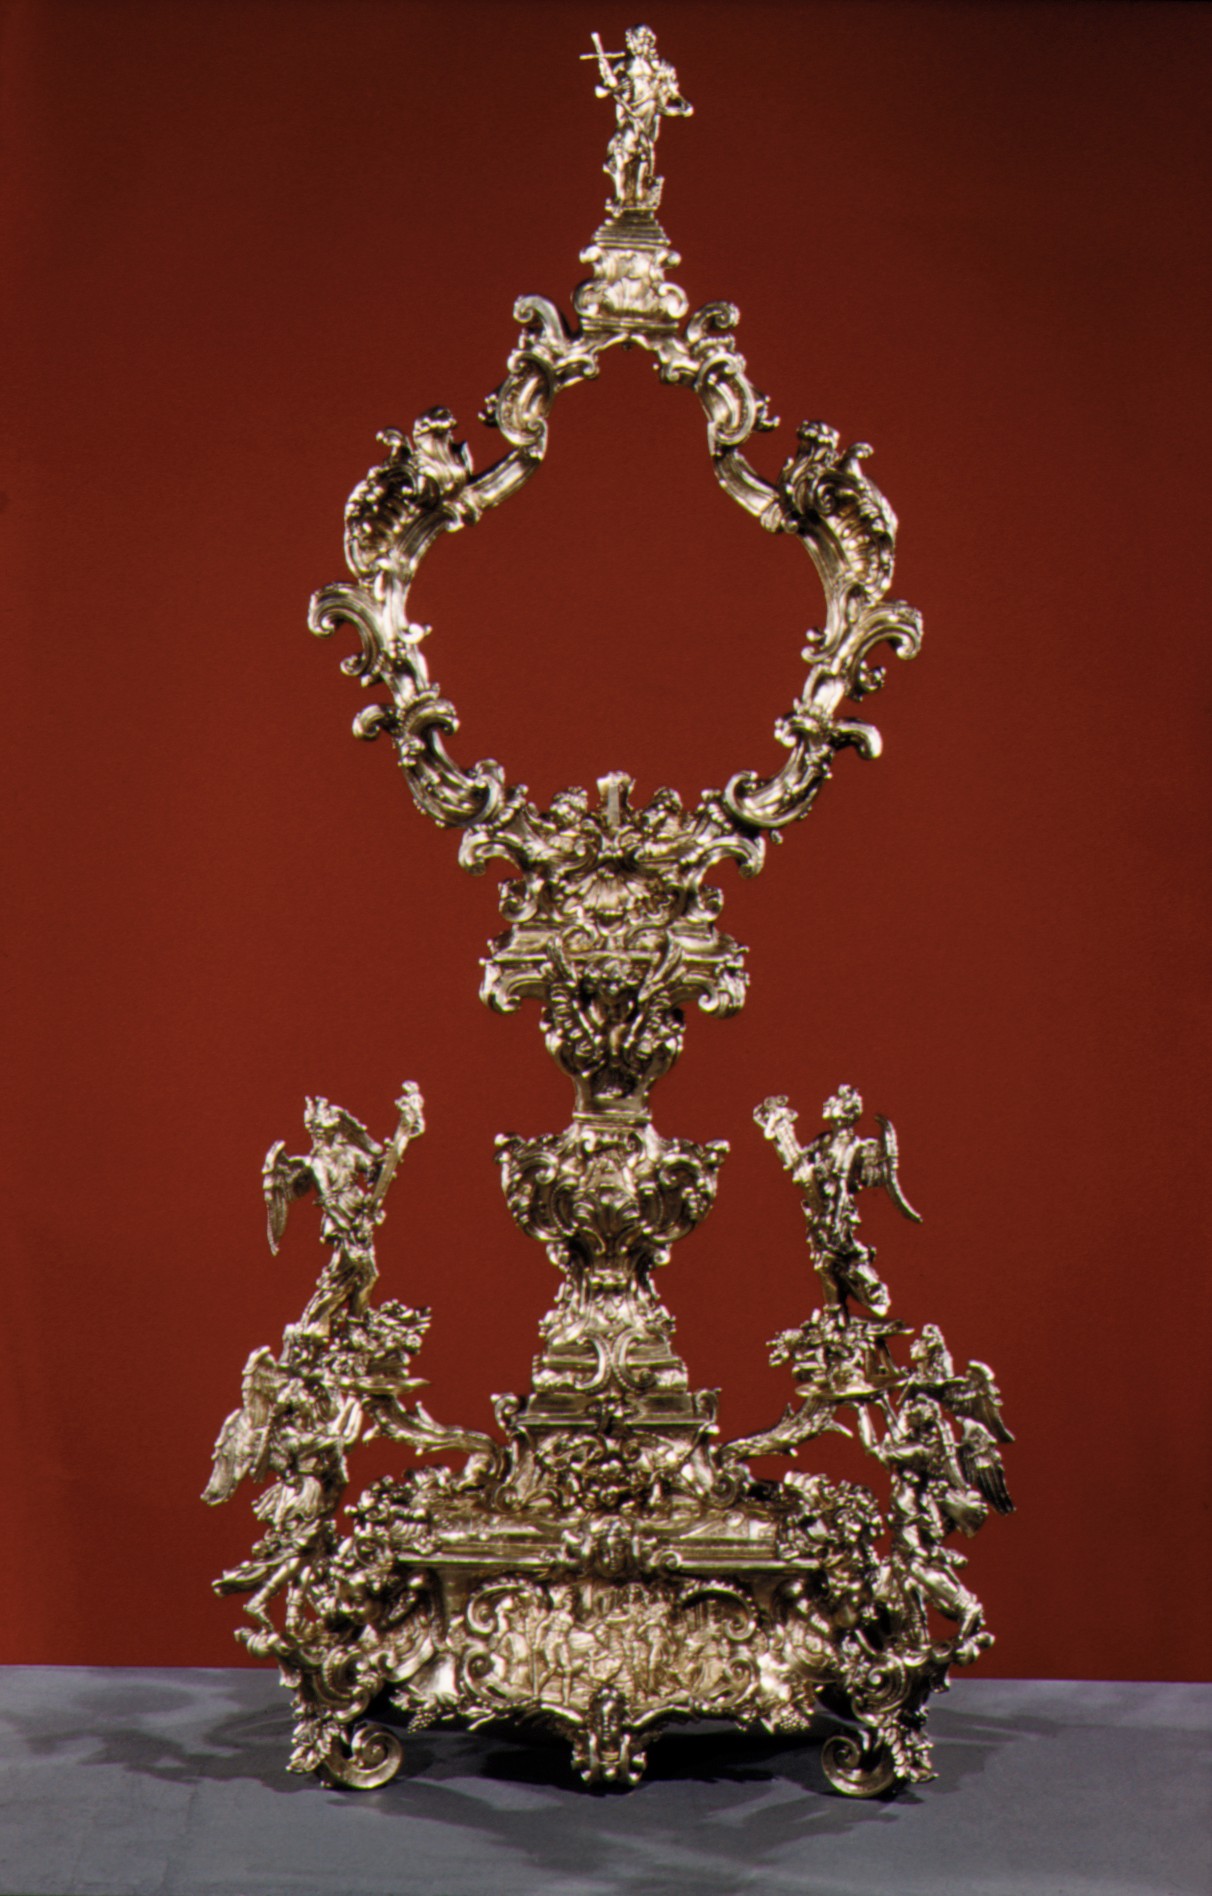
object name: reliquary monstrance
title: Reliquary monstrance of St. John the Baptist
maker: c. c.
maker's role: maker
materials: silver gilt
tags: angels,saint john the baptist,reliquaries